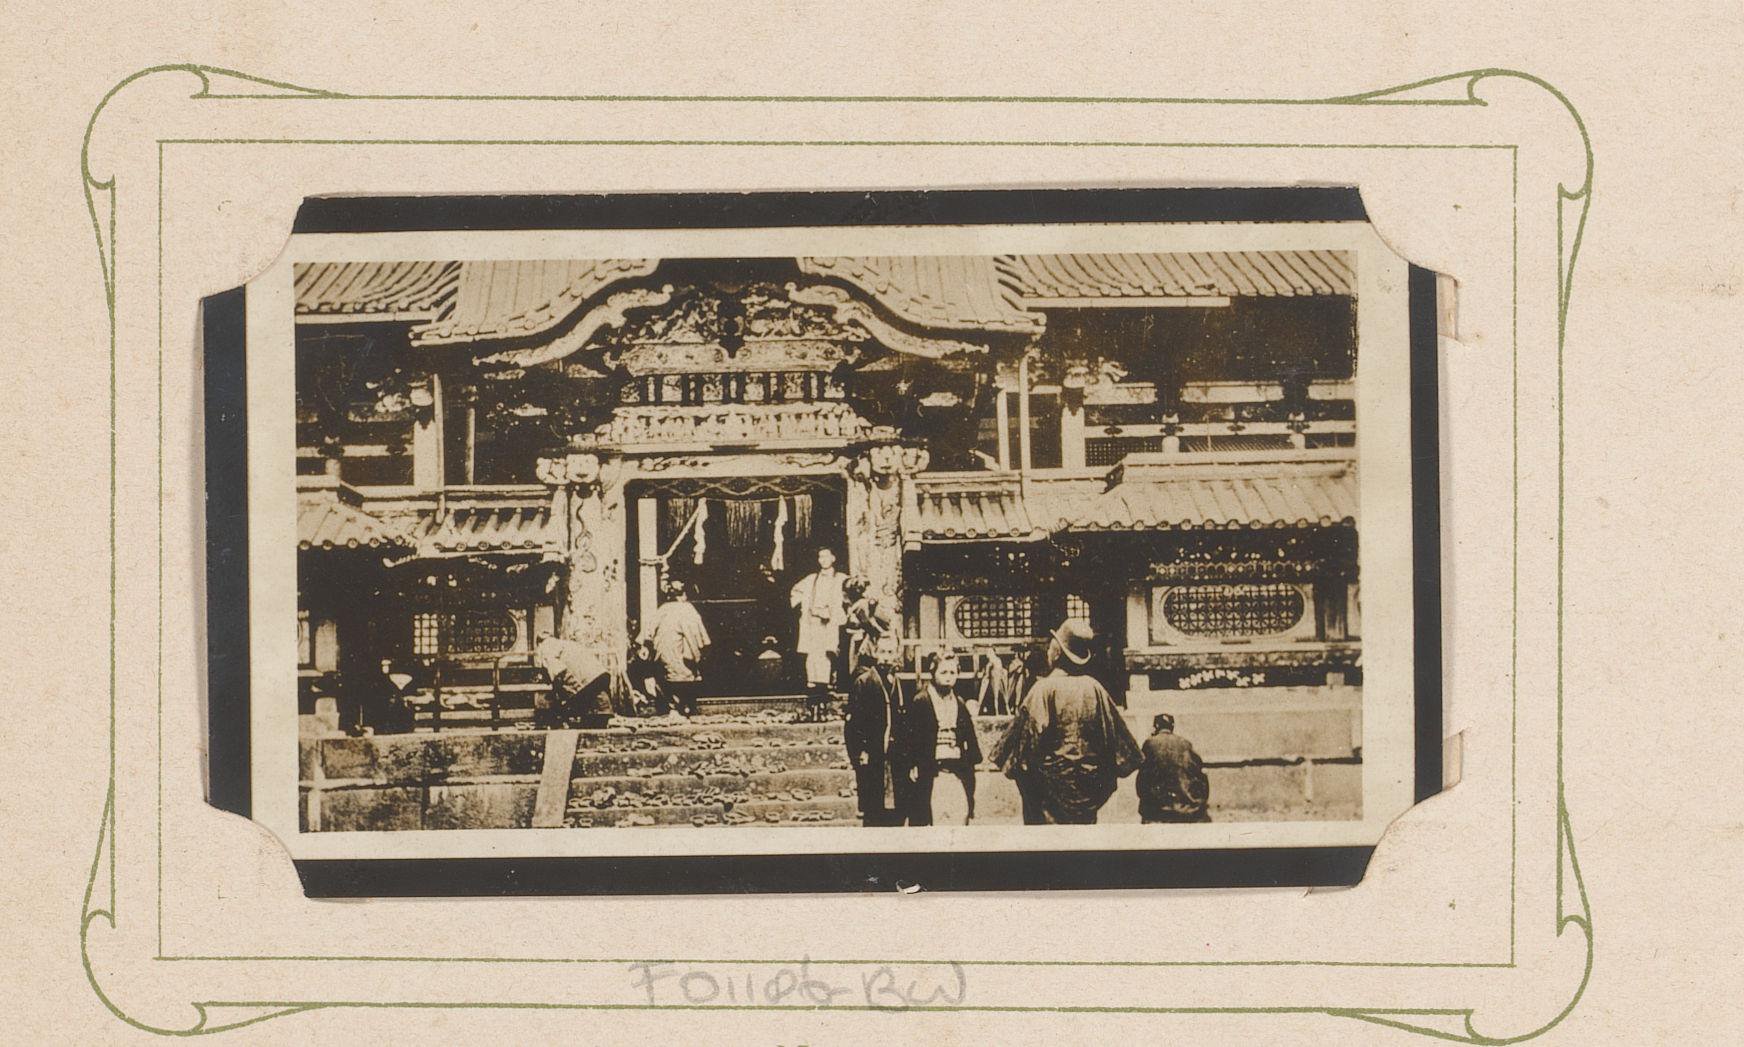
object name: album leaf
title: Gezicht op de Nikko Toshugo te Nikko, Japan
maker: Anonymous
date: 1904-1905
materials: photographic support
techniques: gelatin silver print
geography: nikko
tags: temple, shrine ~ shinto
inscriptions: inscription: ‘No. 3./ Jajaskerk te Nikko.’